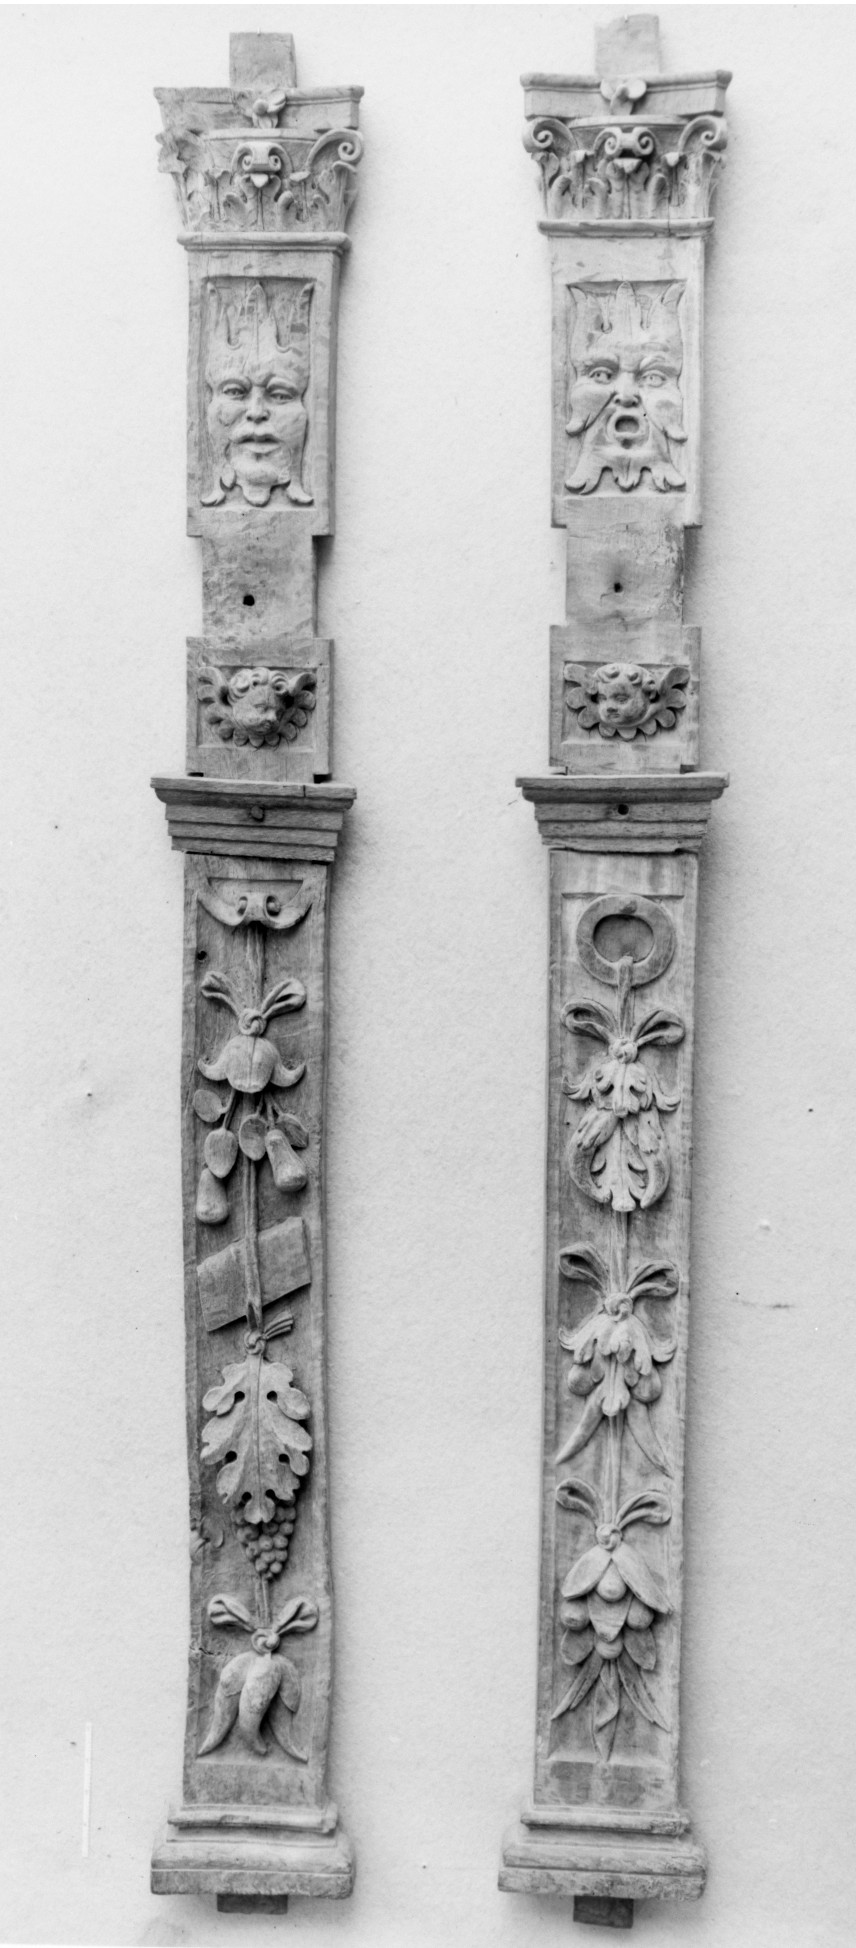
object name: pilaster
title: Pair of pilasters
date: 1501-1550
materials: wood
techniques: carving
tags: masks,grapes